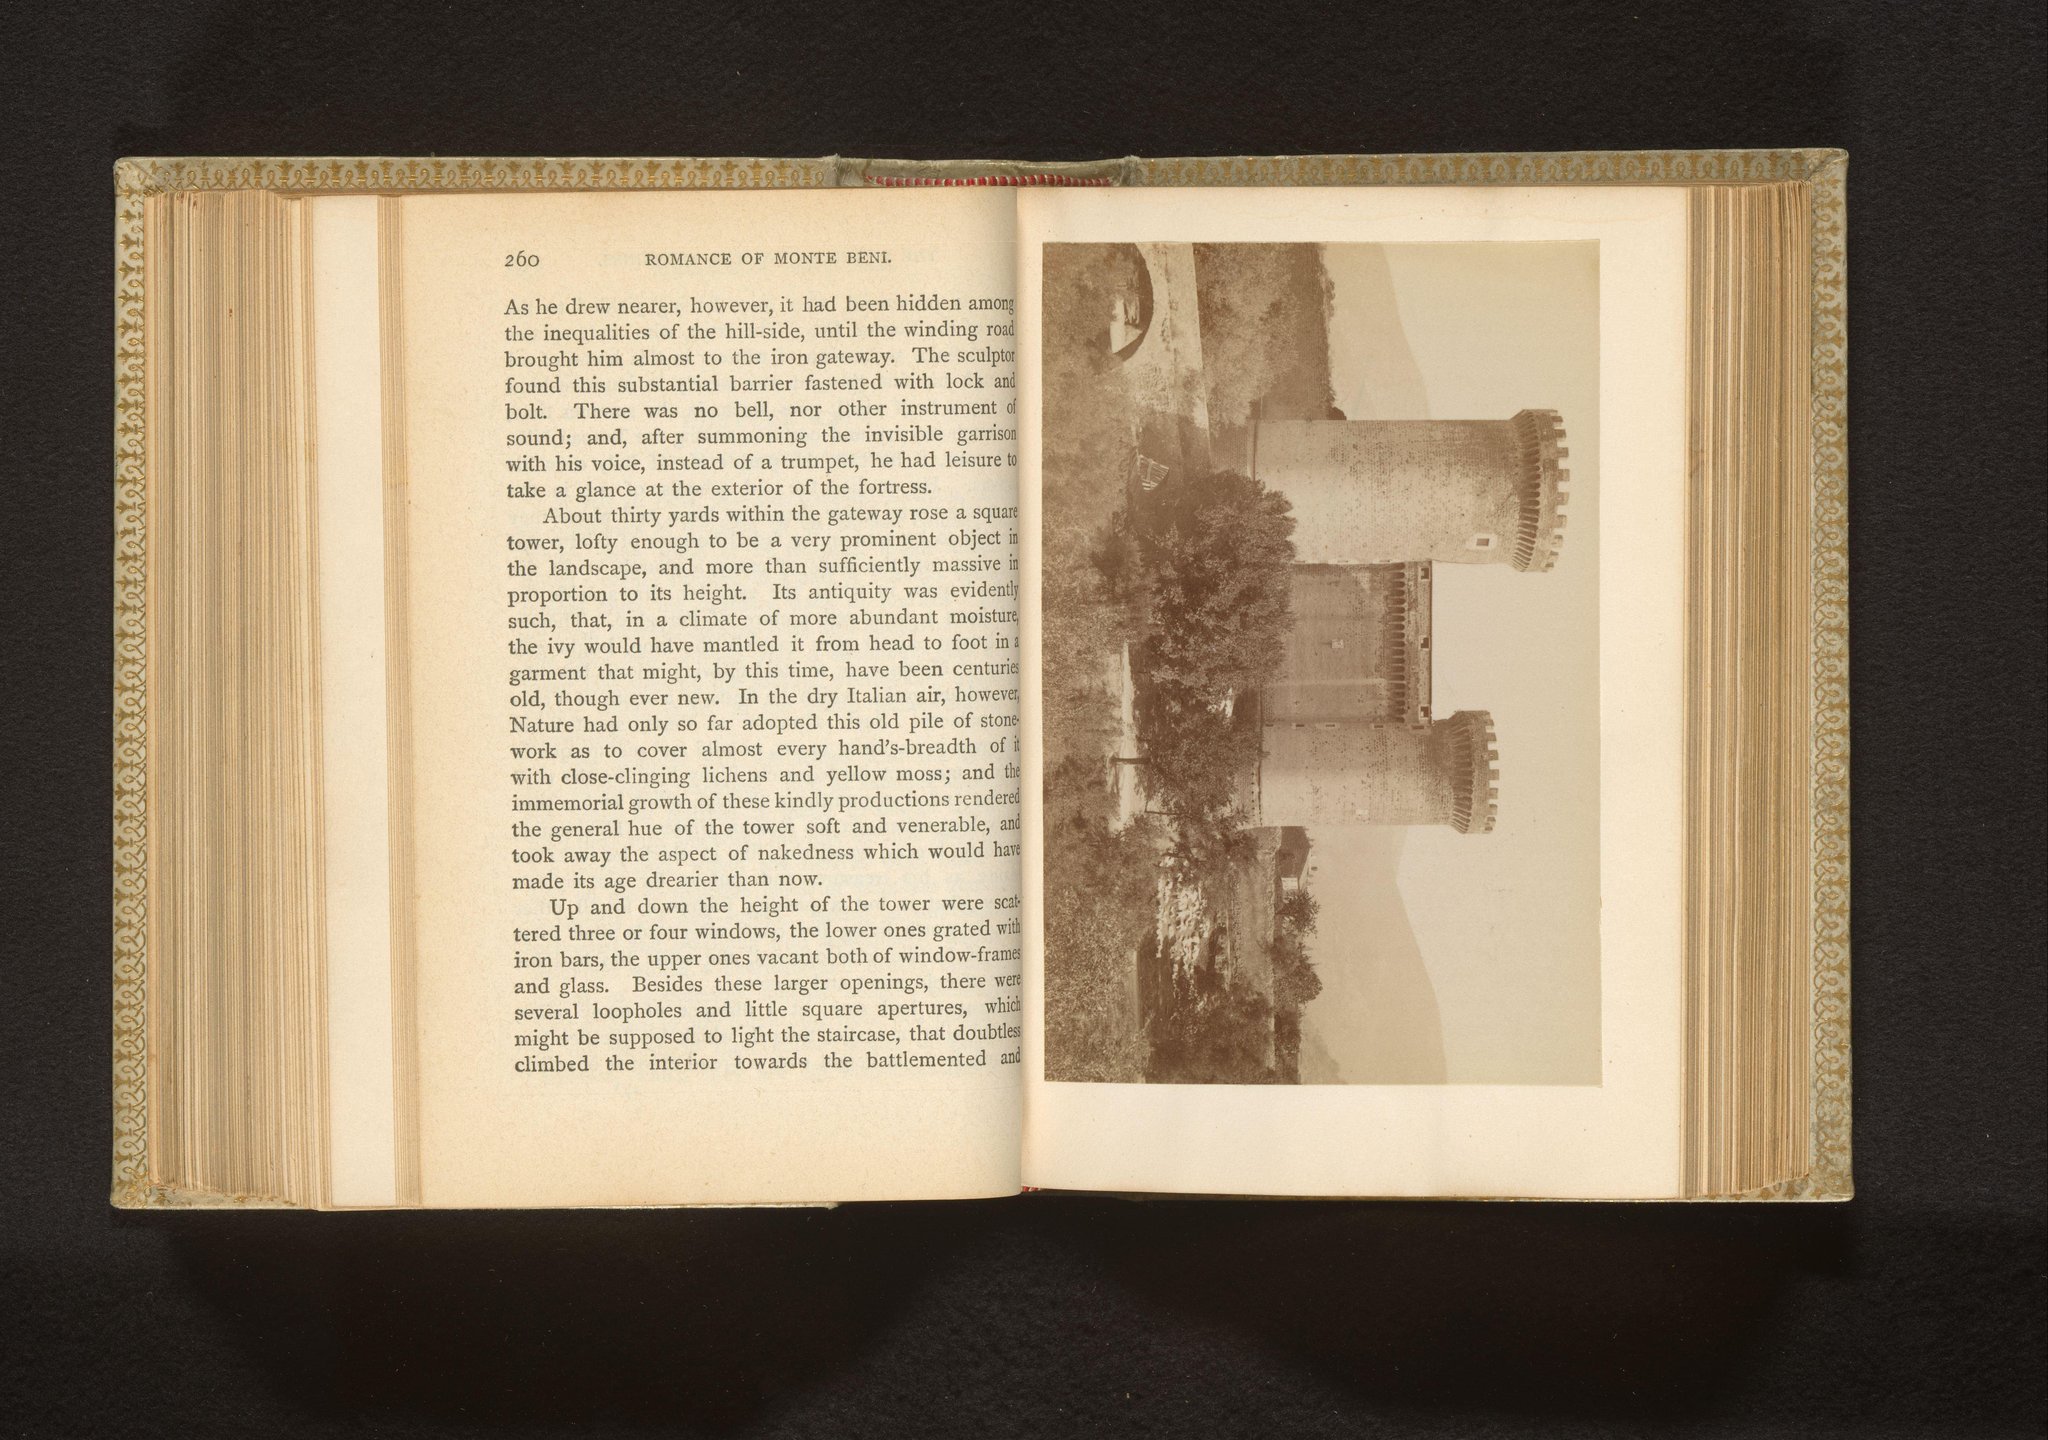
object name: page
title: Gezicht op een fort in Italië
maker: Anonymous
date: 1850-1860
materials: photographic support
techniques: albumen print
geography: italy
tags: fortress, italy